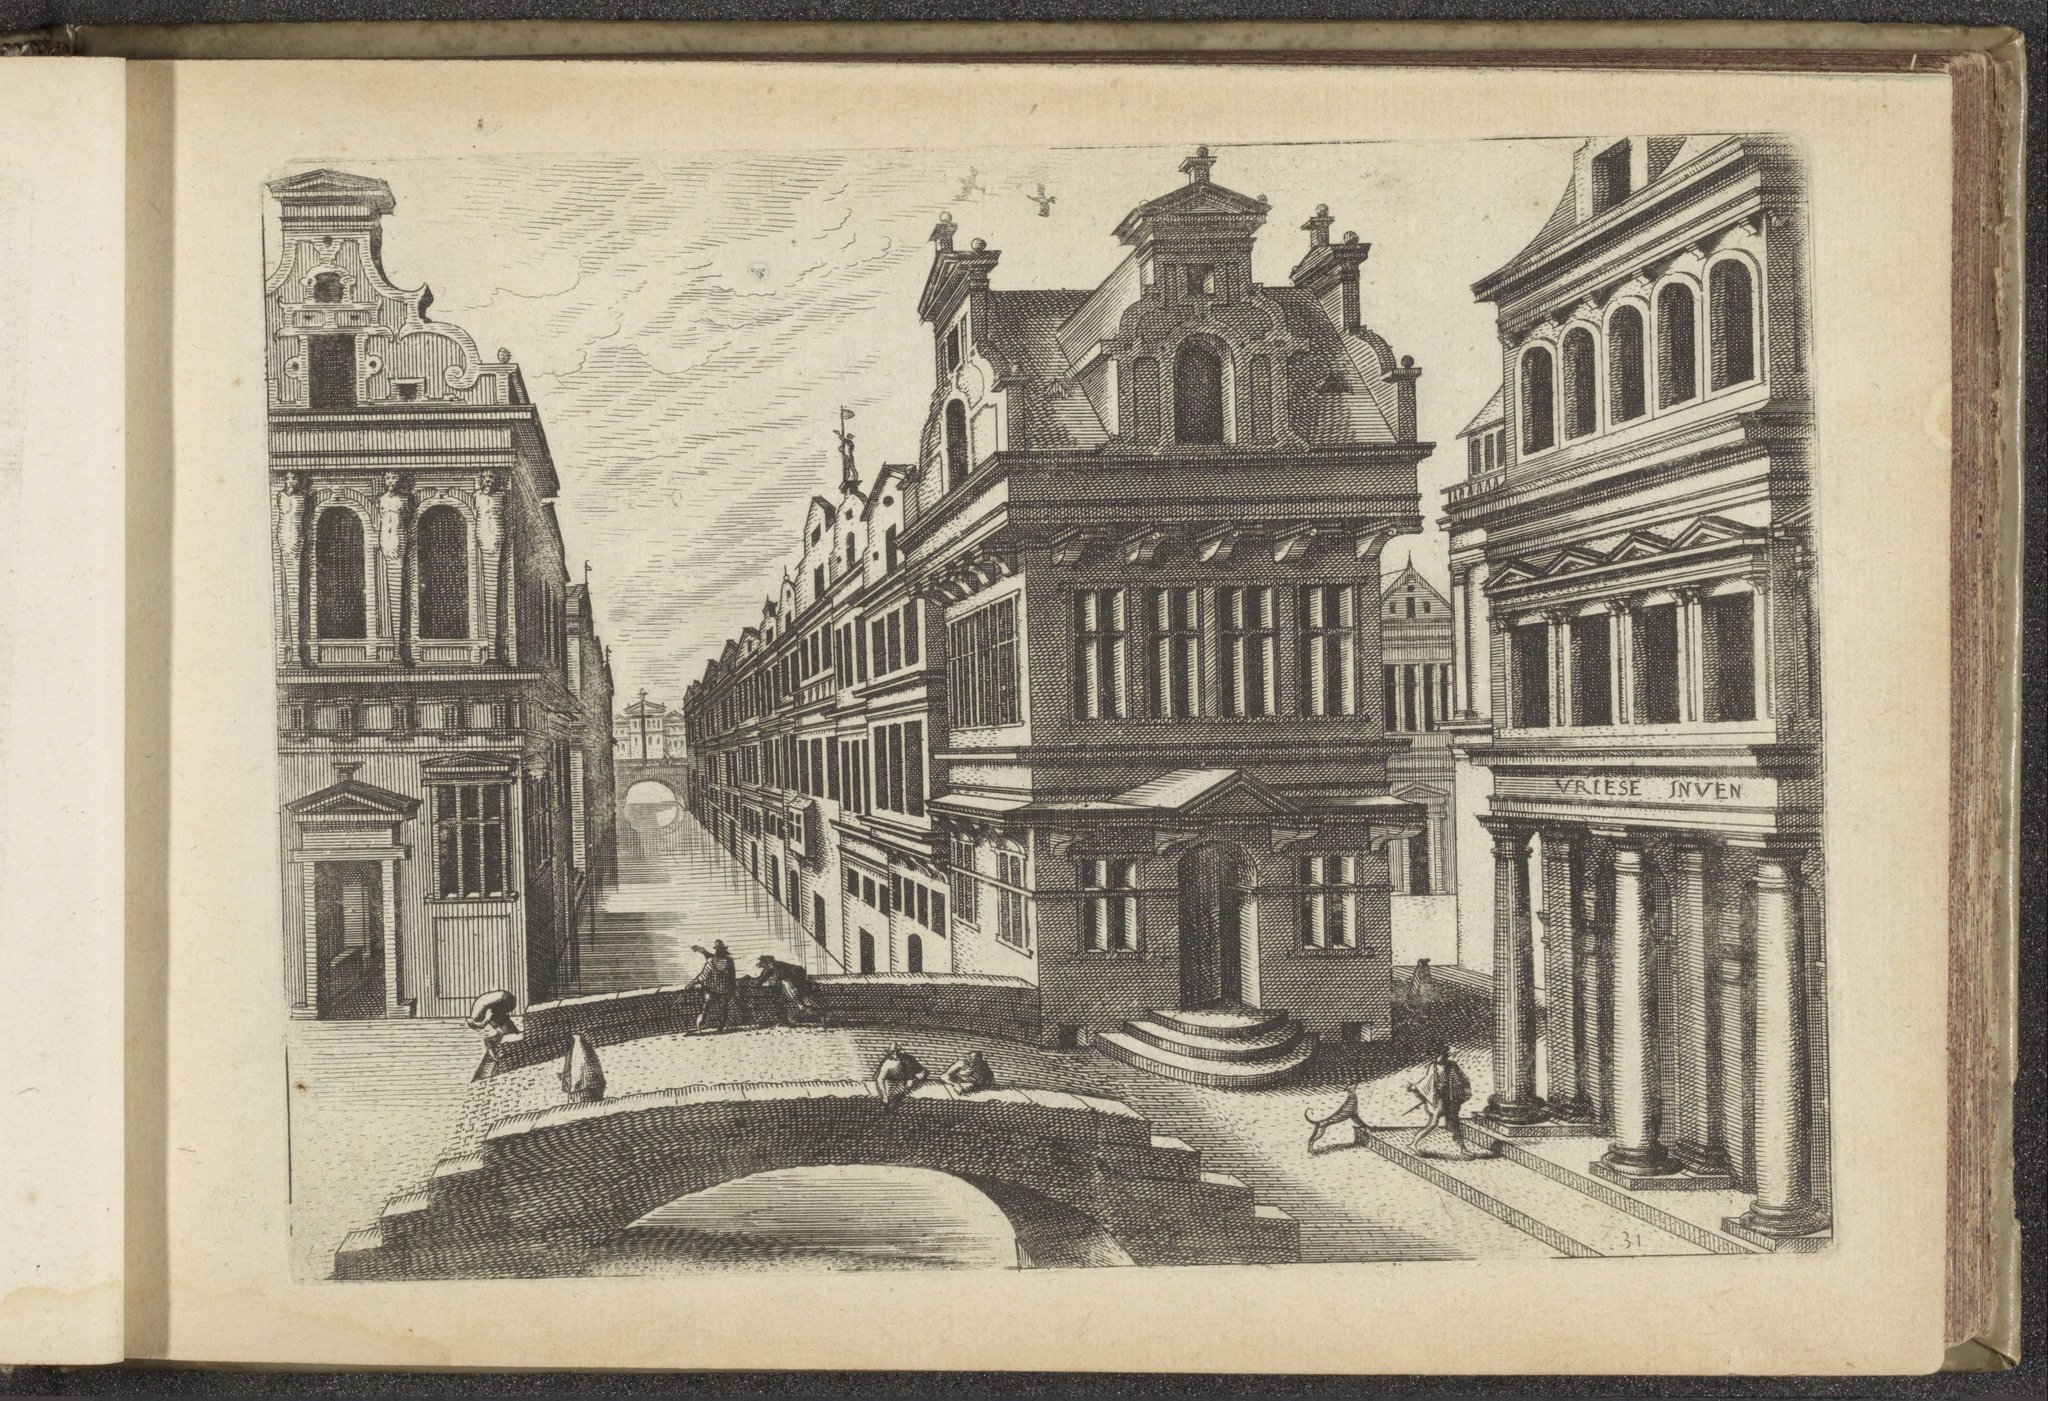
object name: print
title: Variae Architecturae formae (...)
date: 1562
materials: paper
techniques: etching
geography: antwerp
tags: architectural representations in general, canal, street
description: Gezicht op een gracht met gebouwen aan weerszijden. Op de voorgrond figuren op een brug. Rechts een gebouw met zuilen van de Toscaande orde. Deze prent maakt deel uit van een album.